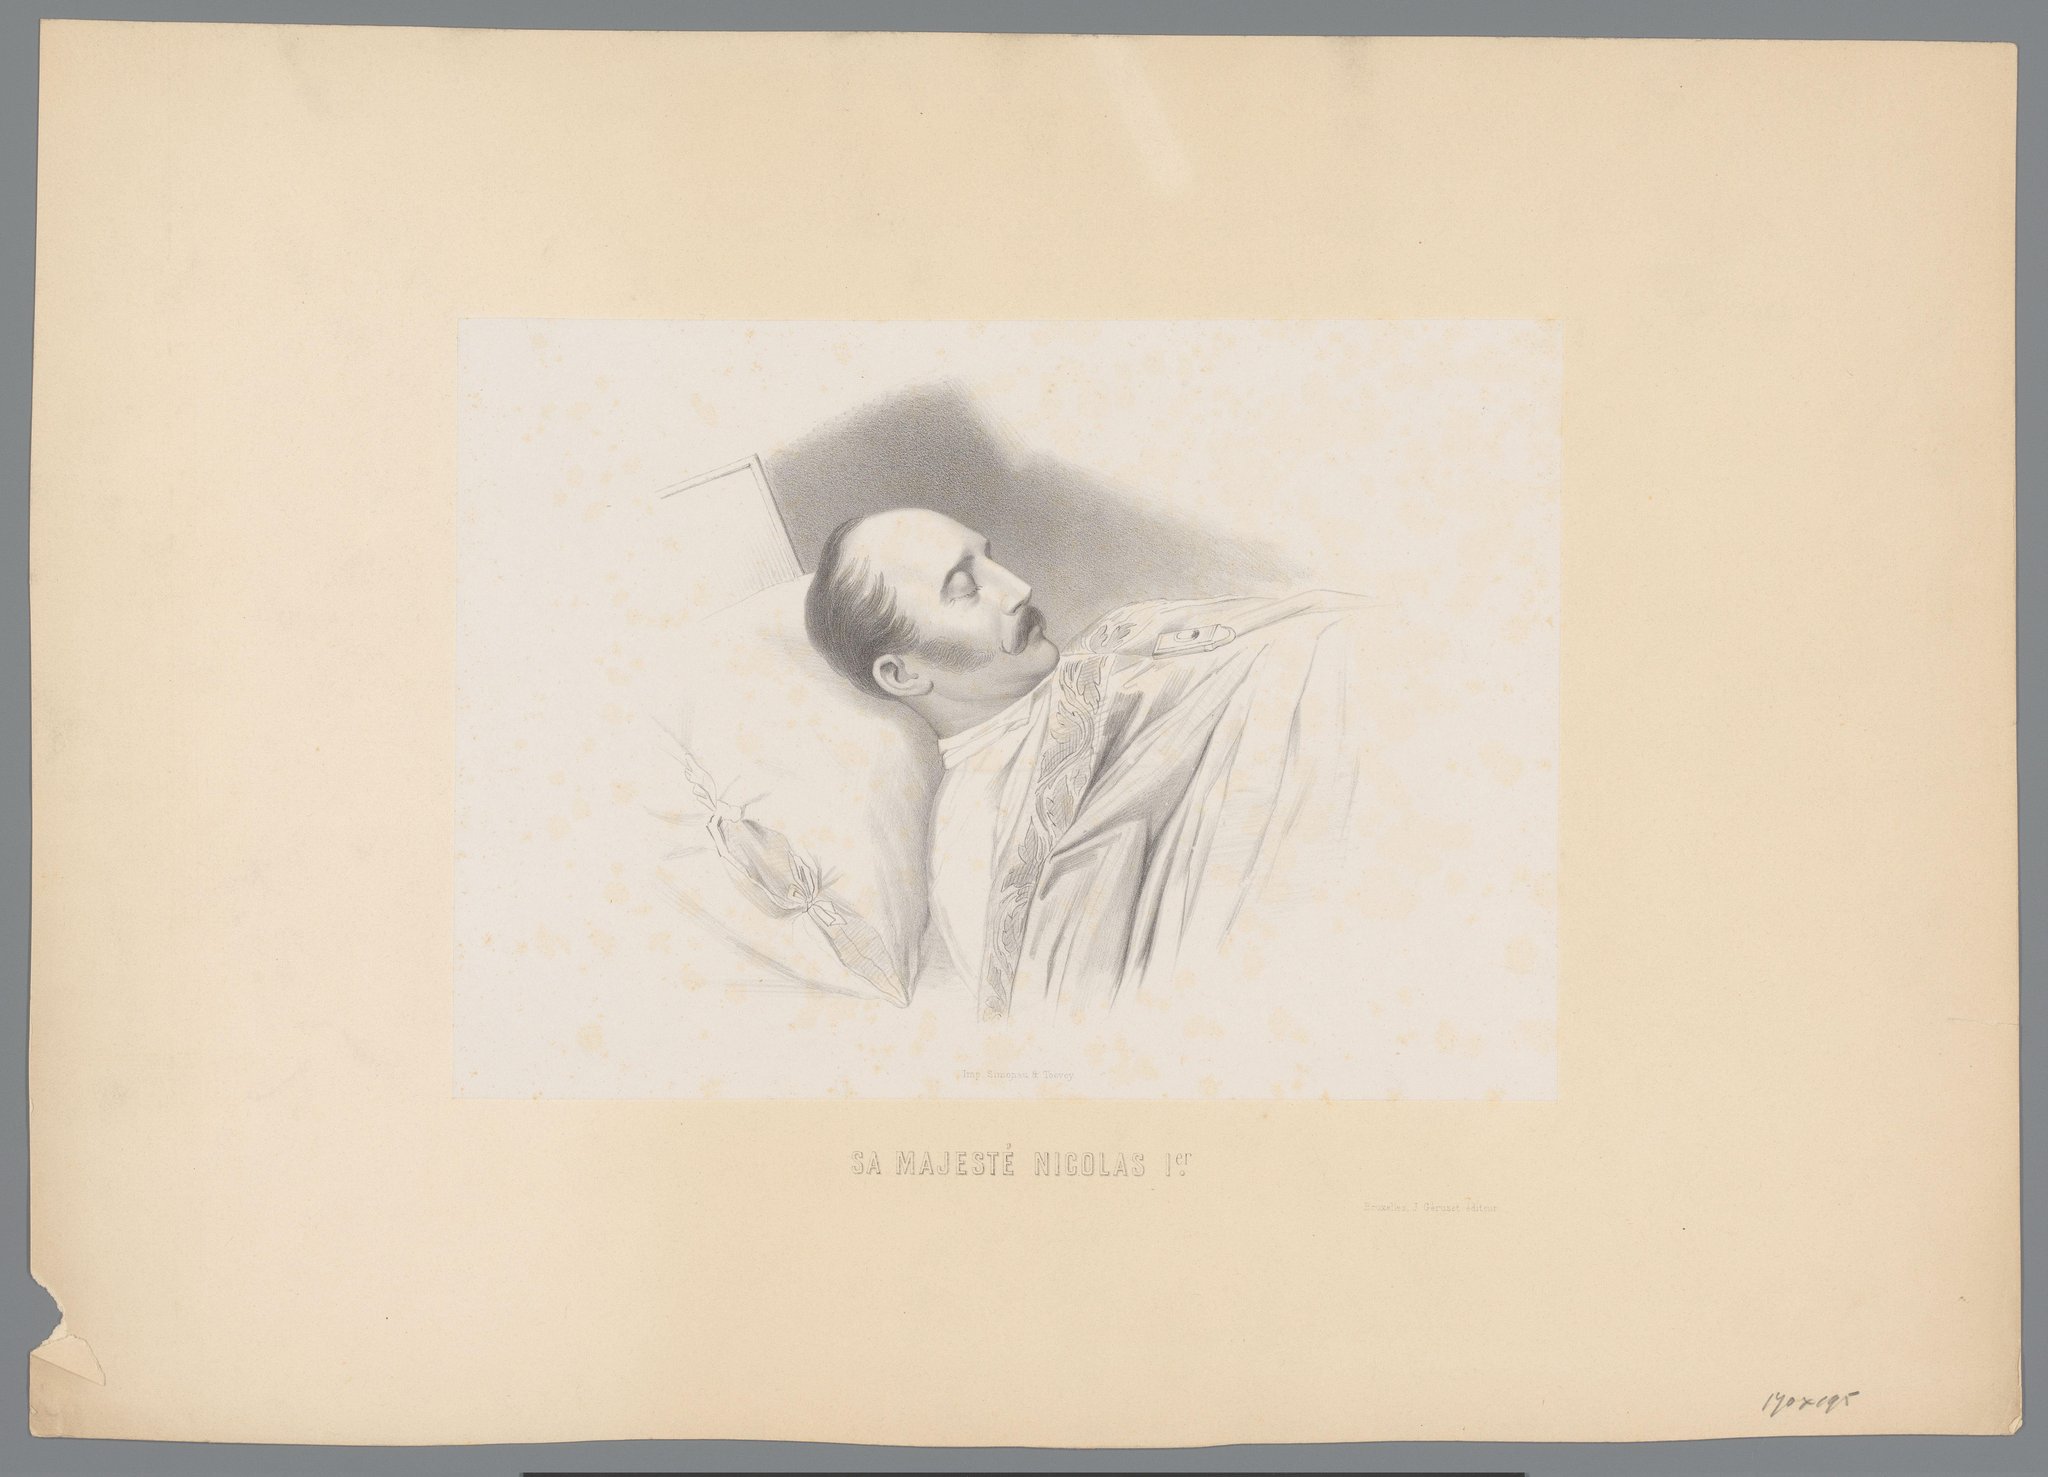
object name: print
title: Nicolaas I Pavlovitsj op zijn sterfbed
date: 1847-1875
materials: paper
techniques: lithograph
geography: brussels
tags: deathbed, historical persons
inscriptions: collector's mark: Lugt 2228